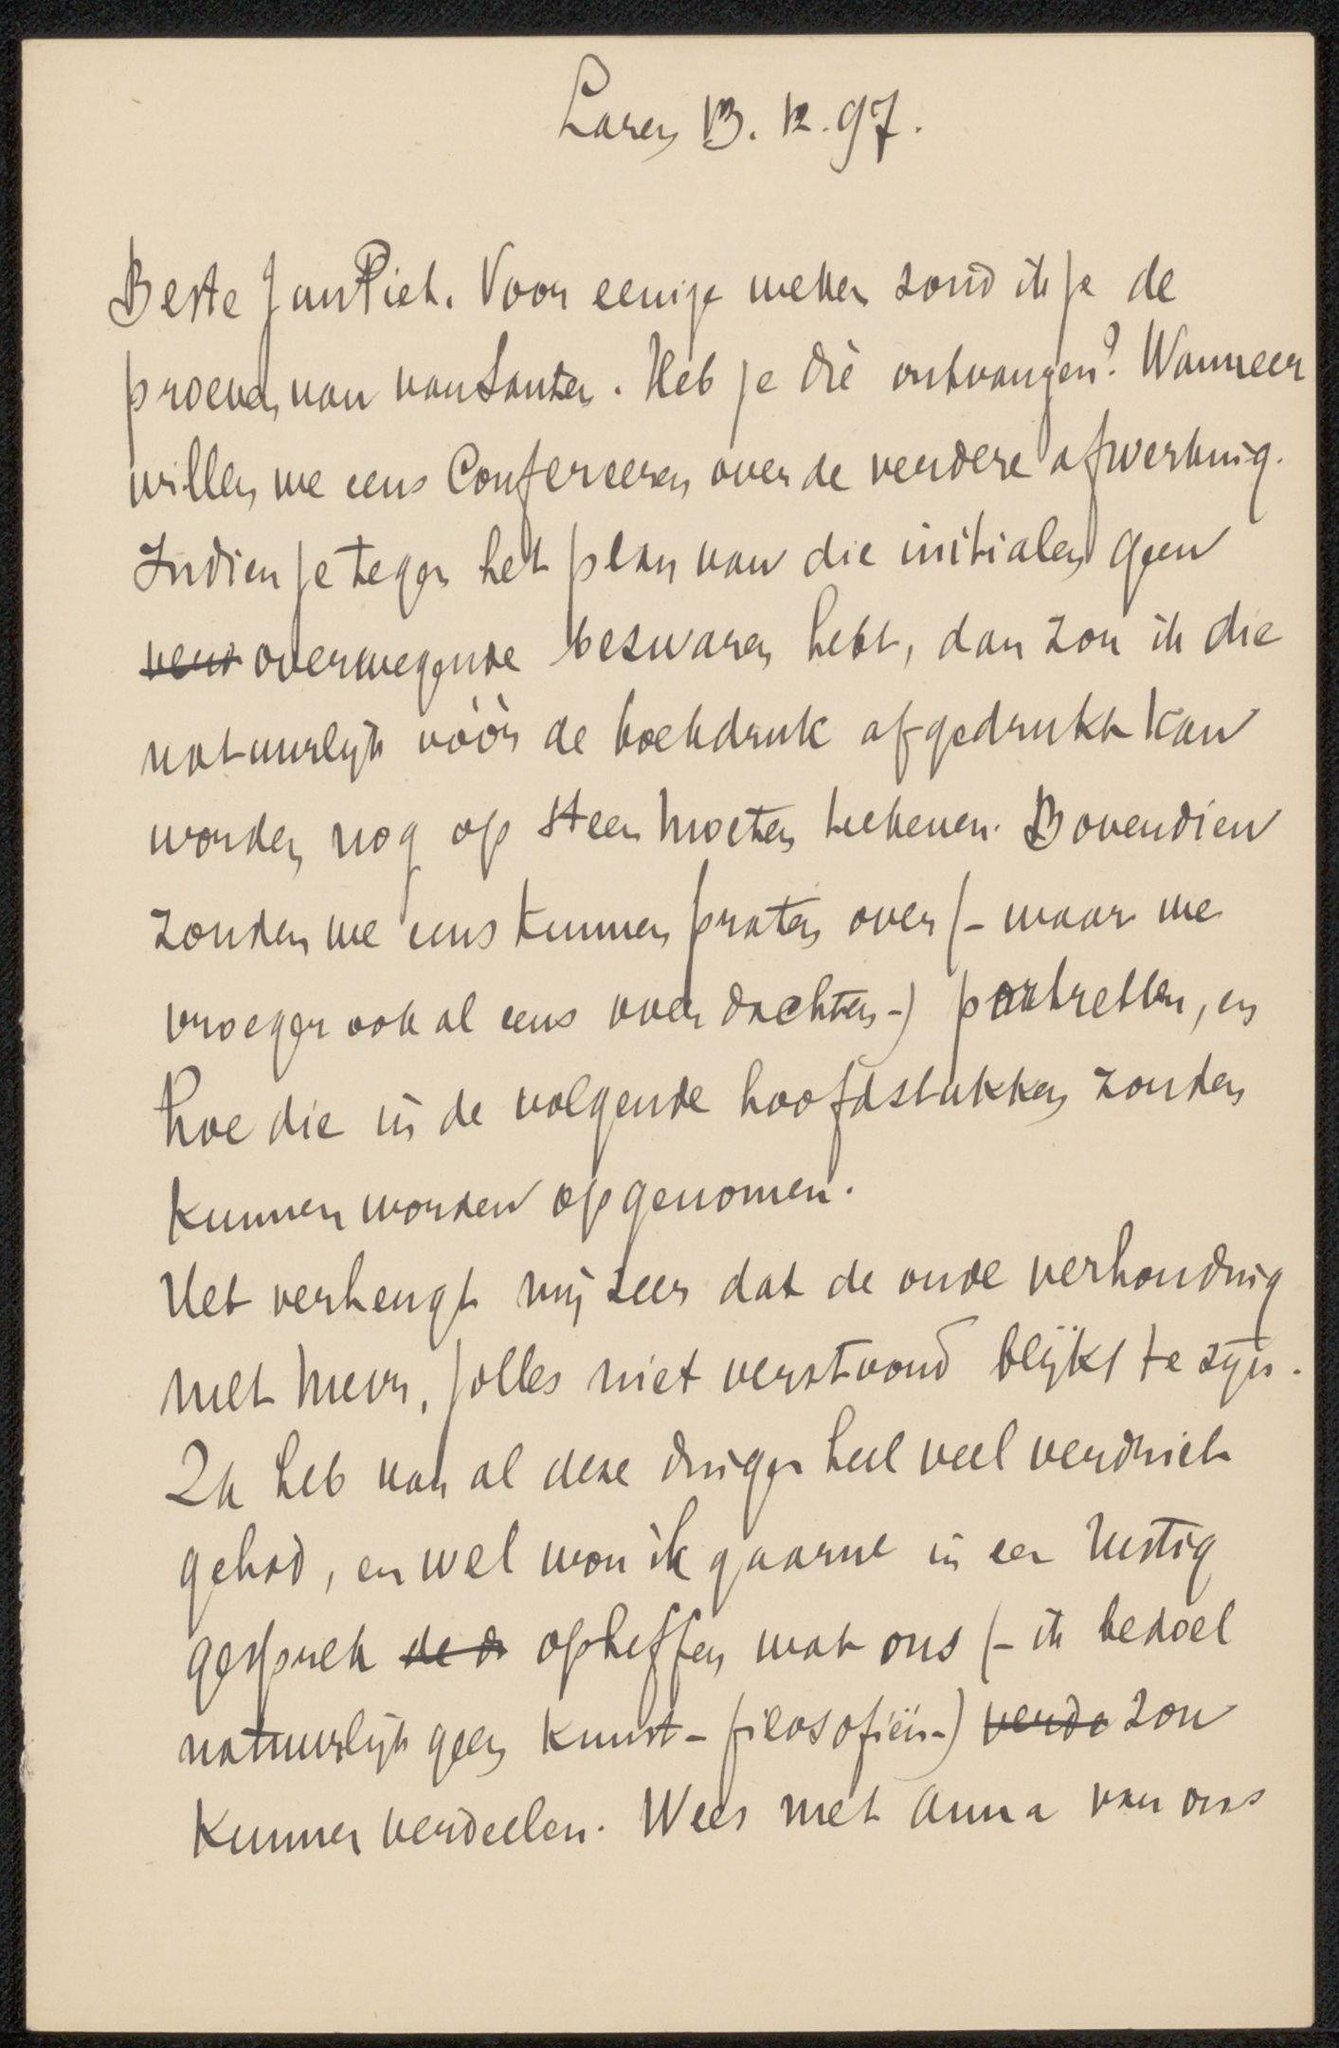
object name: letter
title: Brief aan Jan Veth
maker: antoon derkinderen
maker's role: draughtsman, painter, print maker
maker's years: 1859-1925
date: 1897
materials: ink, paper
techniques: pen, writing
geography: laren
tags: jan veth, amsterdam, jacoba cornelia jolles-singels, anonymous historical person portrayed, printed matter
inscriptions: collector's mark: ‘RPK’